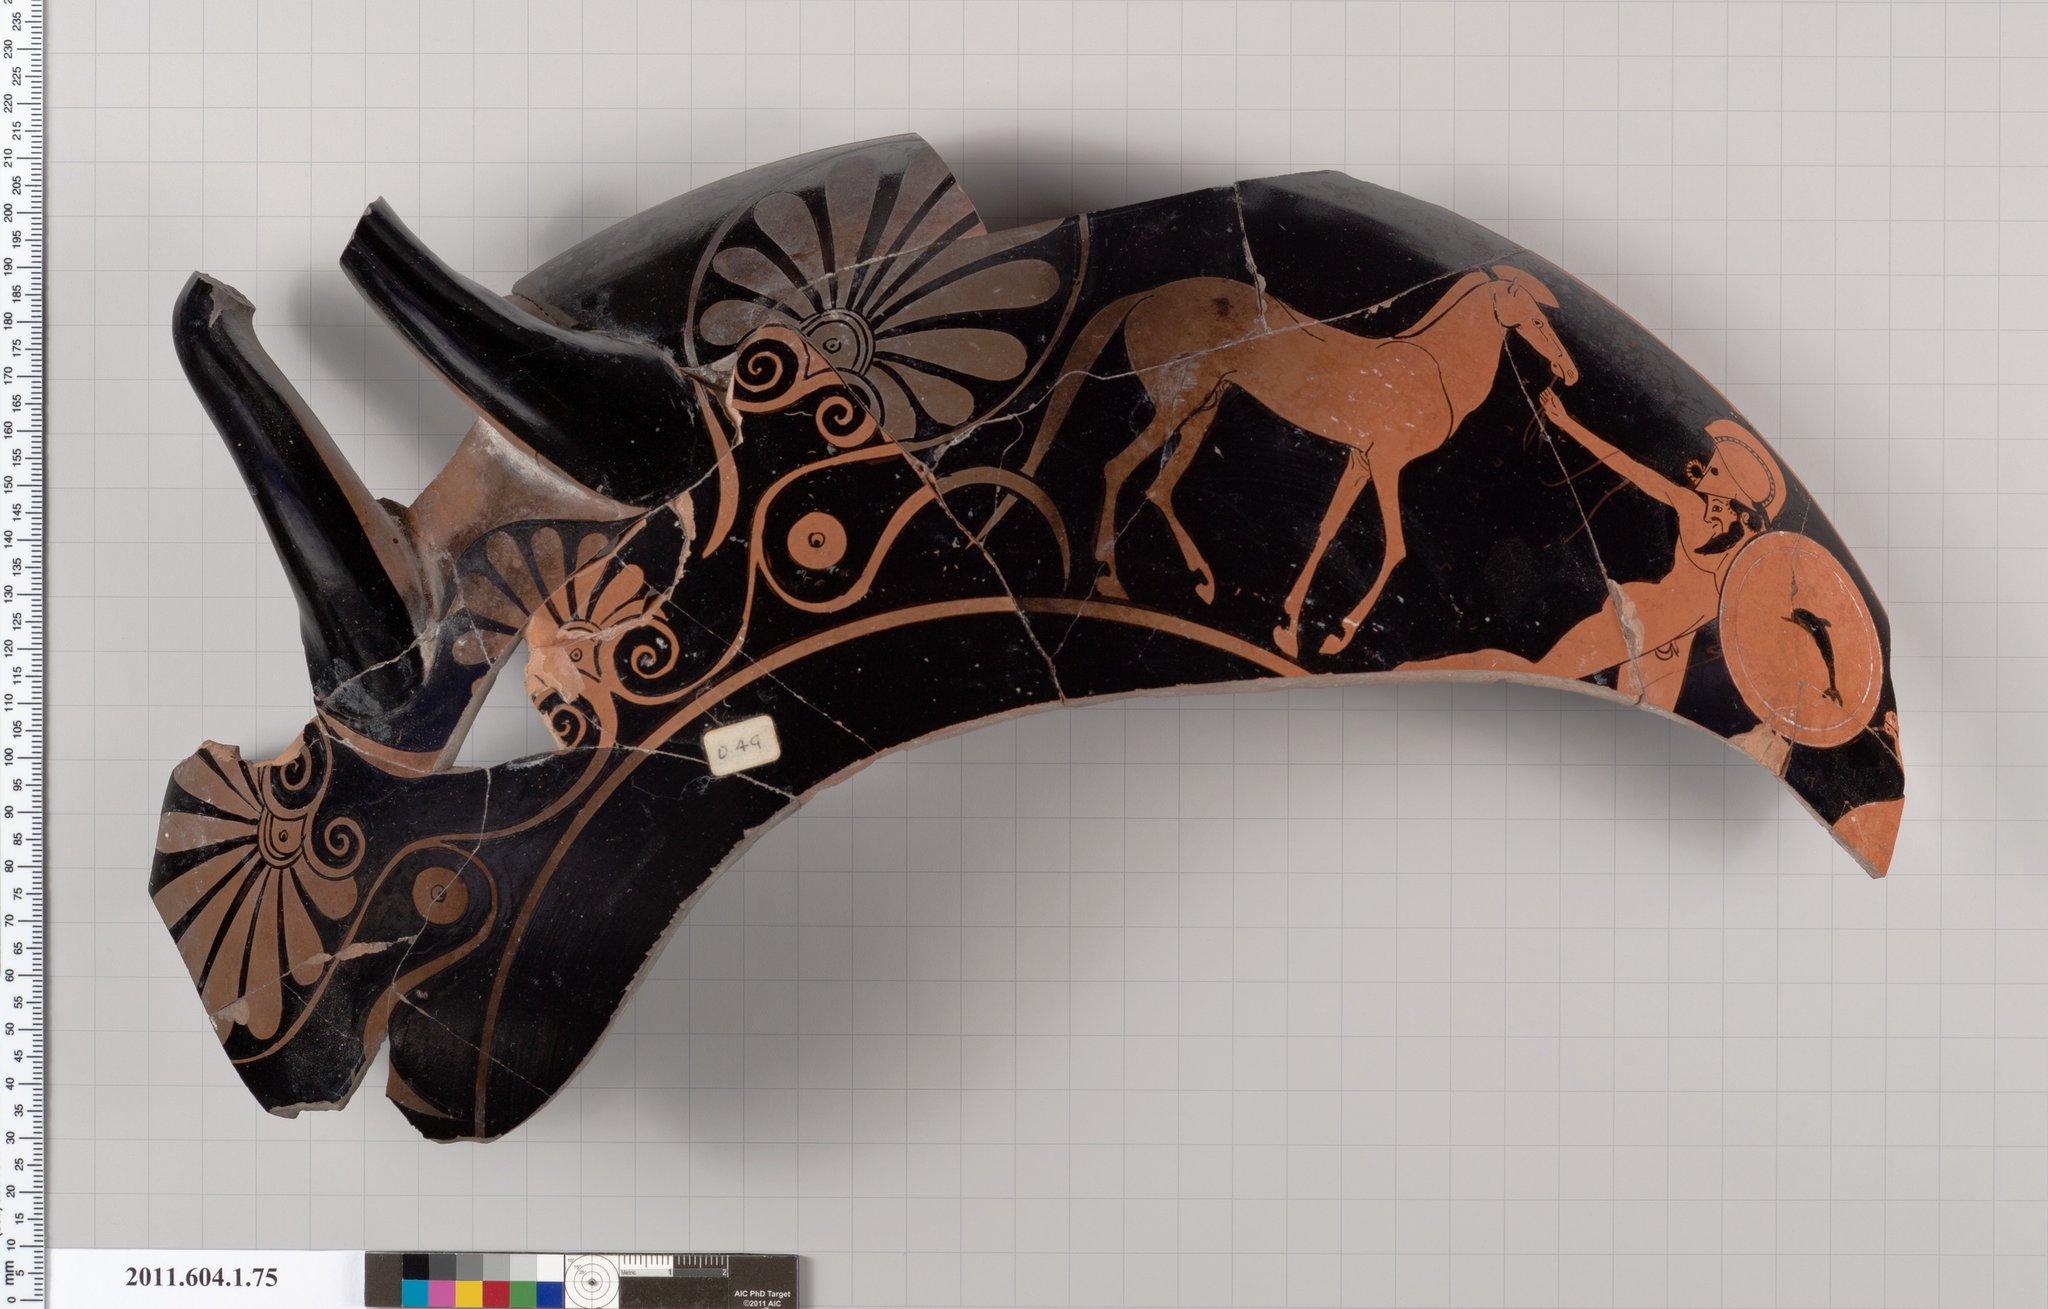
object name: kylix fragment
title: Terracotta fragment of a kylix (drinking cup)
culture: greek, attic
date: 520-500 BCE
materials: terracotta